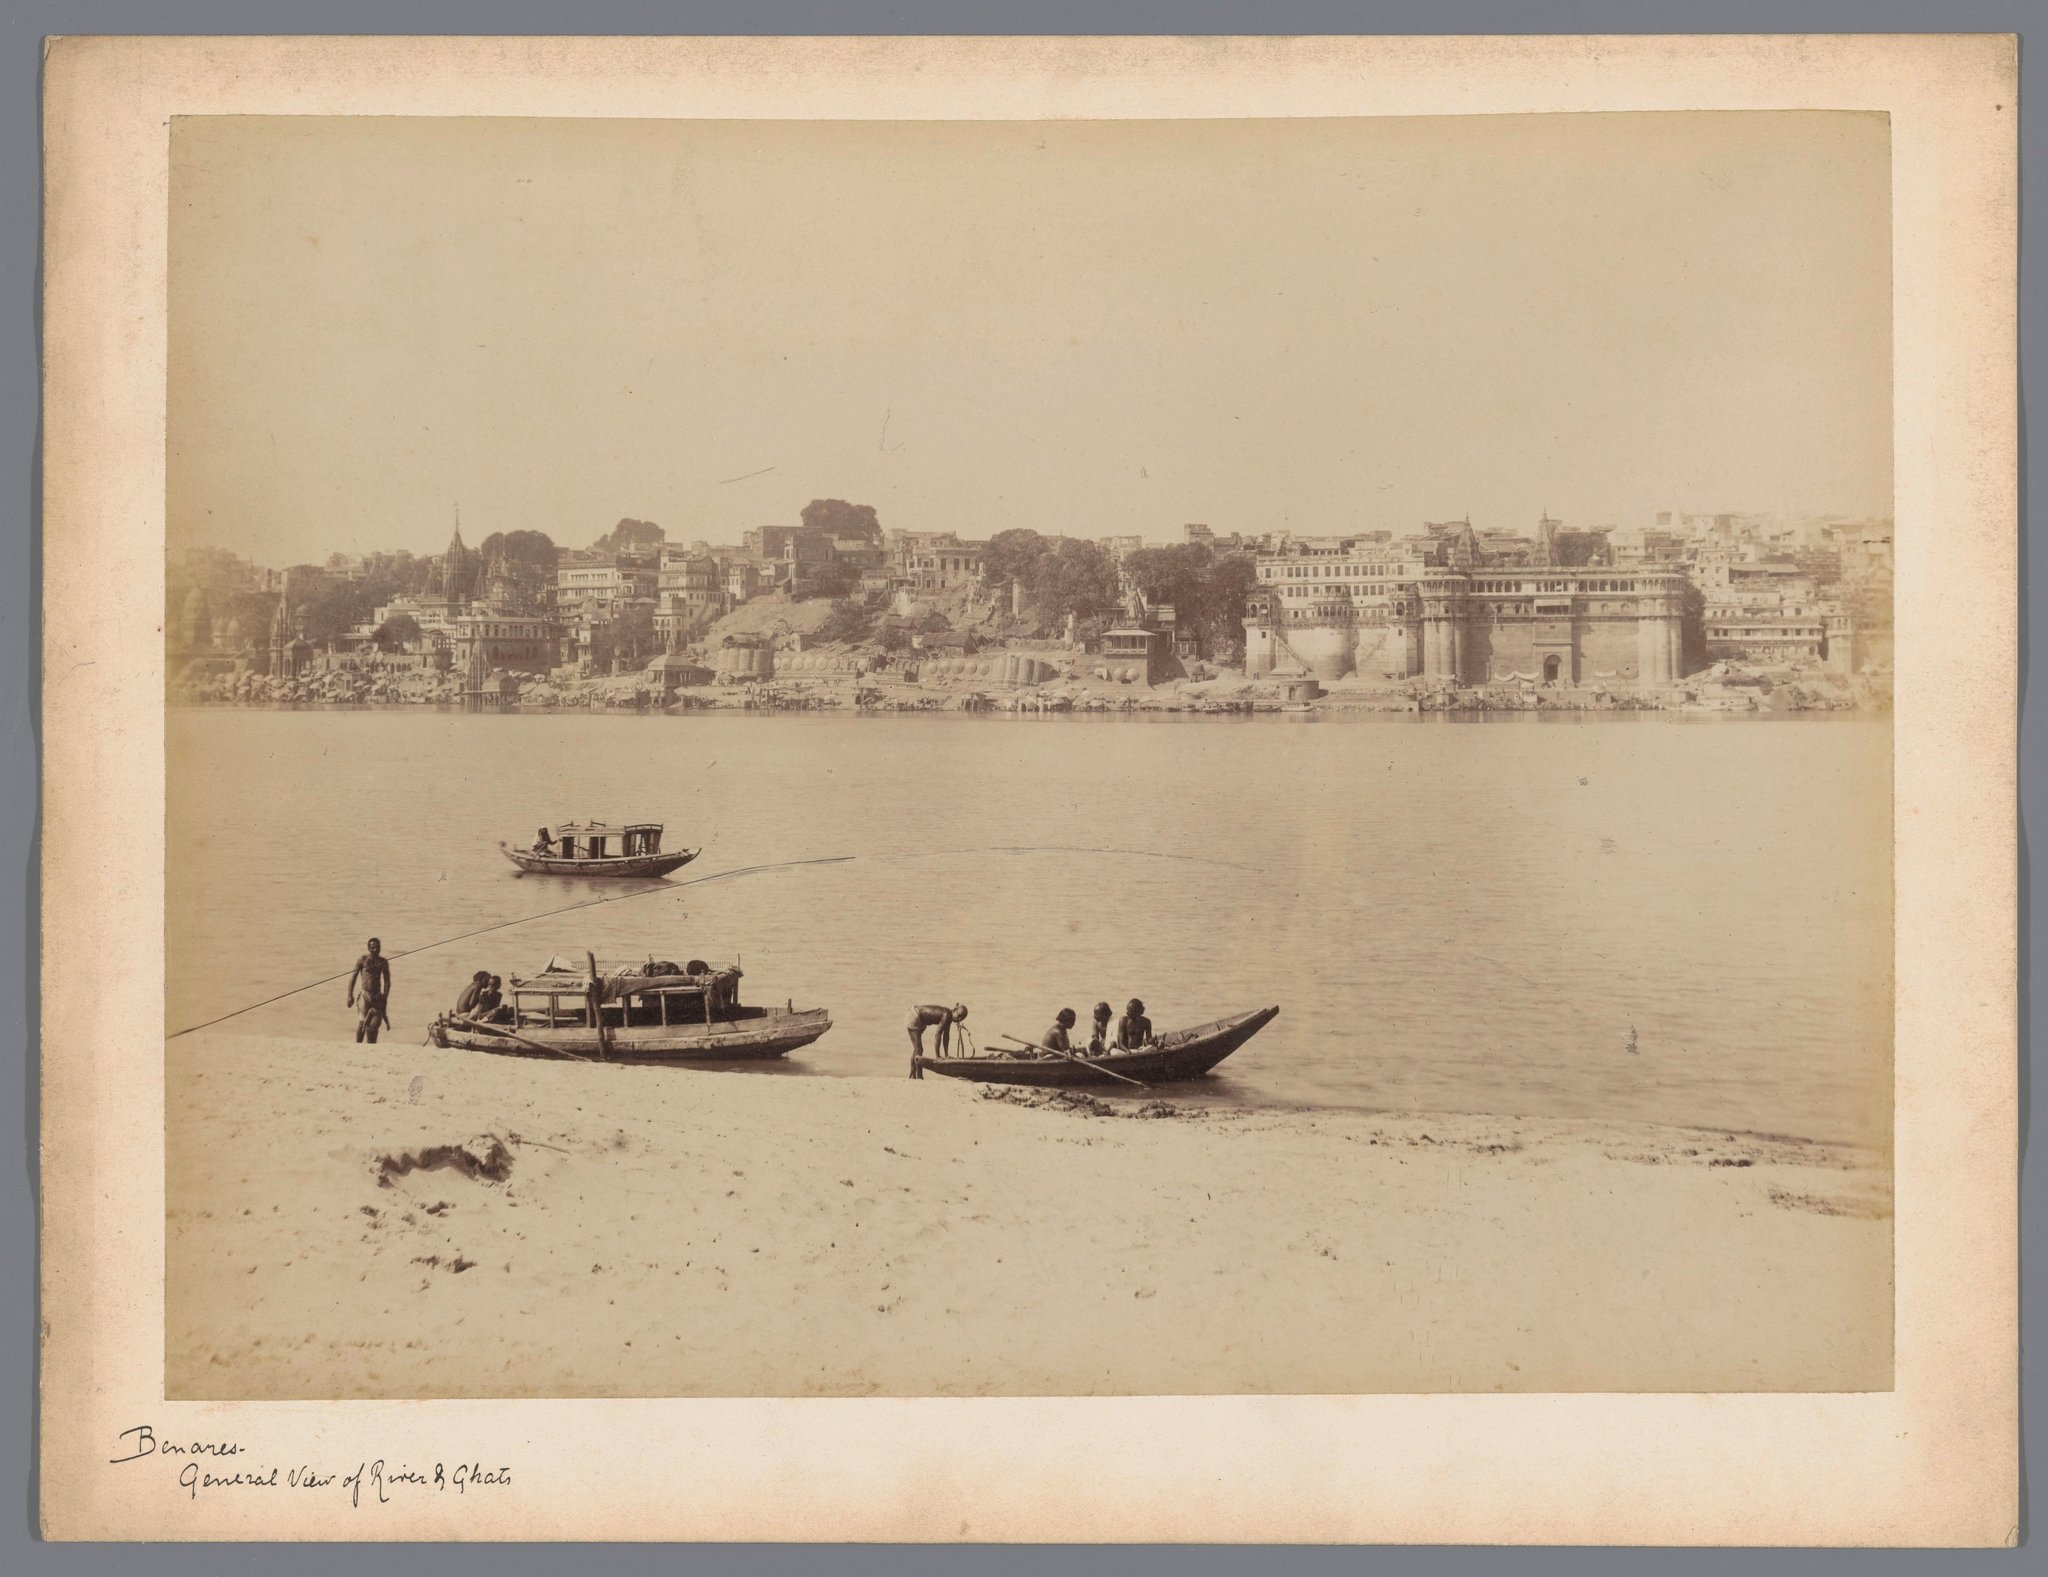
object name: photograph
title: View of the banks of the Ganga in Varanasi, Uttar Pradesh, India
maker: Anonymous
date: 1865-1890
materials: cardboard, paper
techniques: albumen print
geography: varanasi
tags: city-view in general; 'veduta', river, rowing-boat, canoe, etc.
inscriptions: number: ‘7’, title: ‘Benares./ General View of River & Ghats’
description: Een ghat is een heiligdom bestaande uit een heuvel met trappen die afdalen naar een heilige rivier.